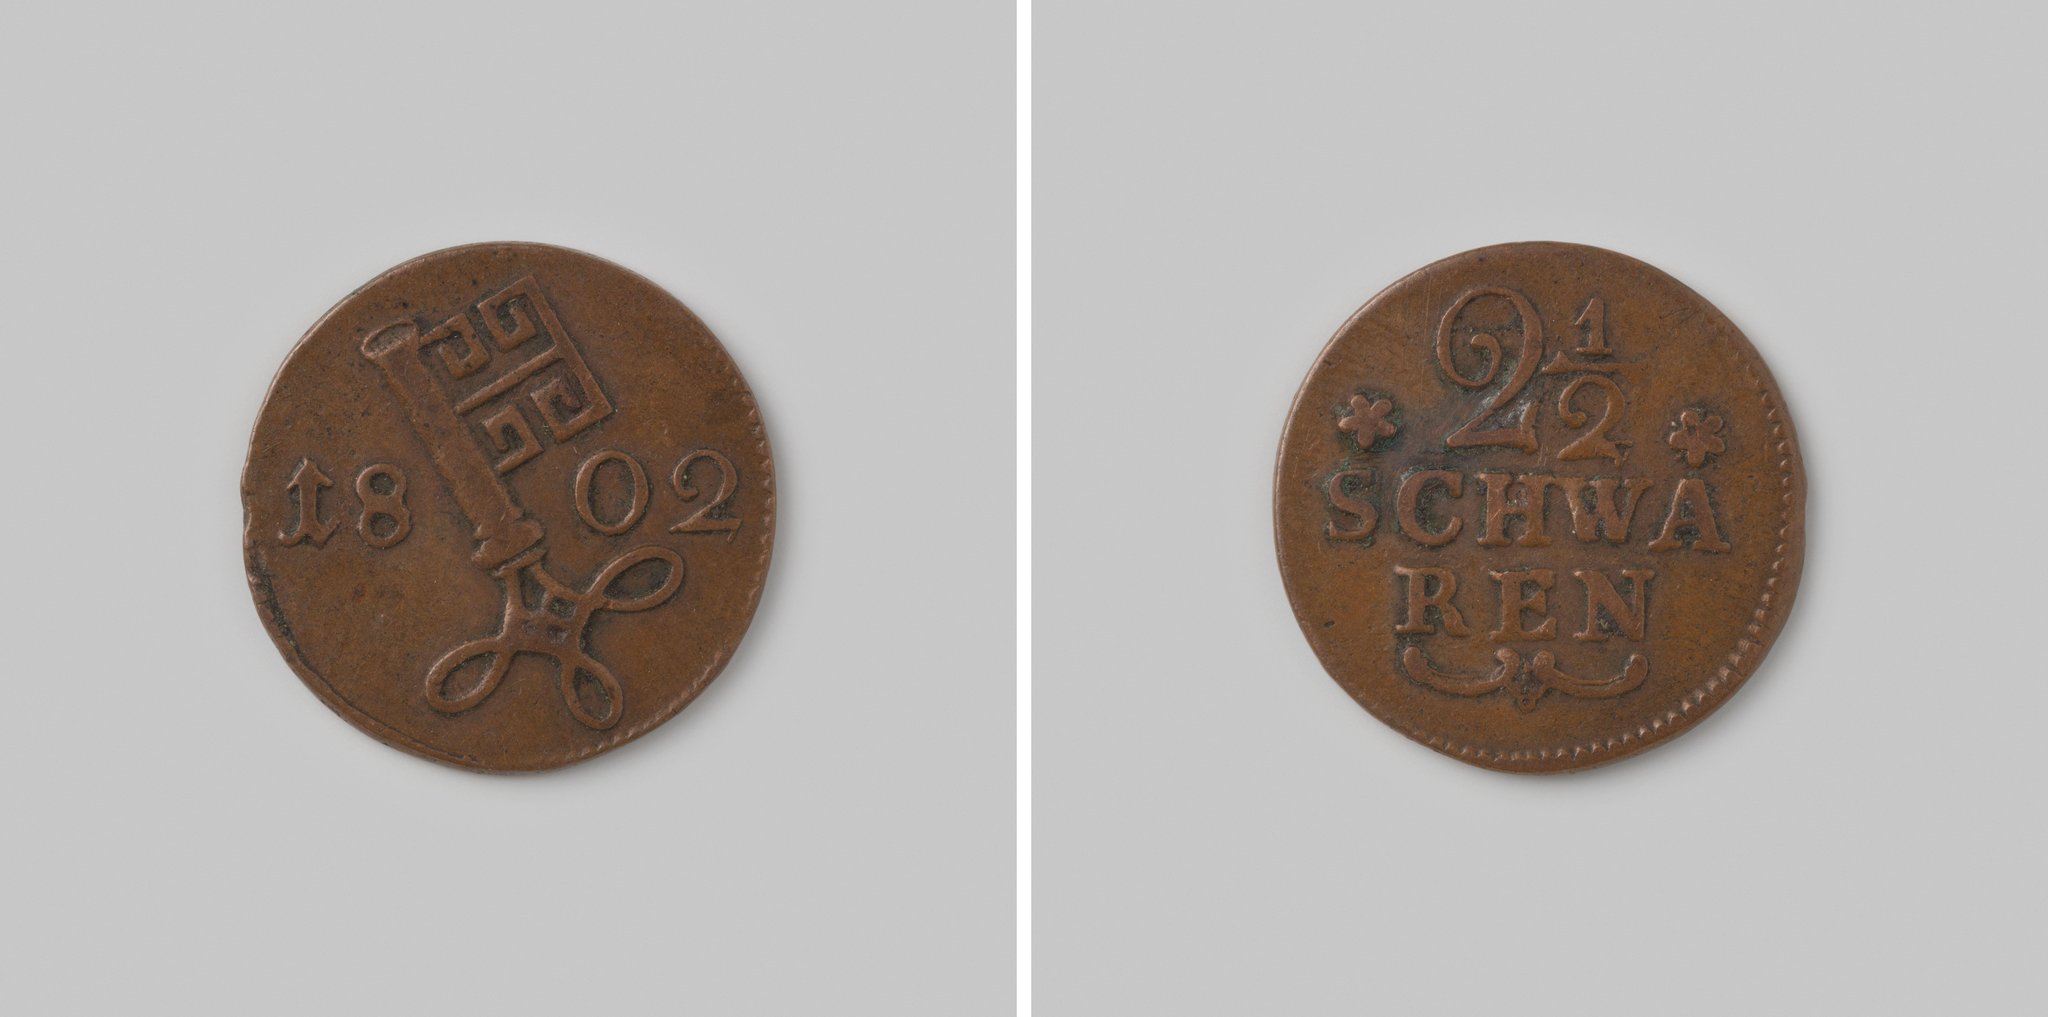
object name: coin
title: Vrije Hansestad Bremen, 2½ Schwaren, 1802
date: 1802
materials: copper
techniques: striking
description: Koperen munt. Voorzijde: tussen jaartal sleutel, wapen van de stad. Keerzijde: waarde-aanduiding in drie regels, waaronder versiering. Gladde rand.